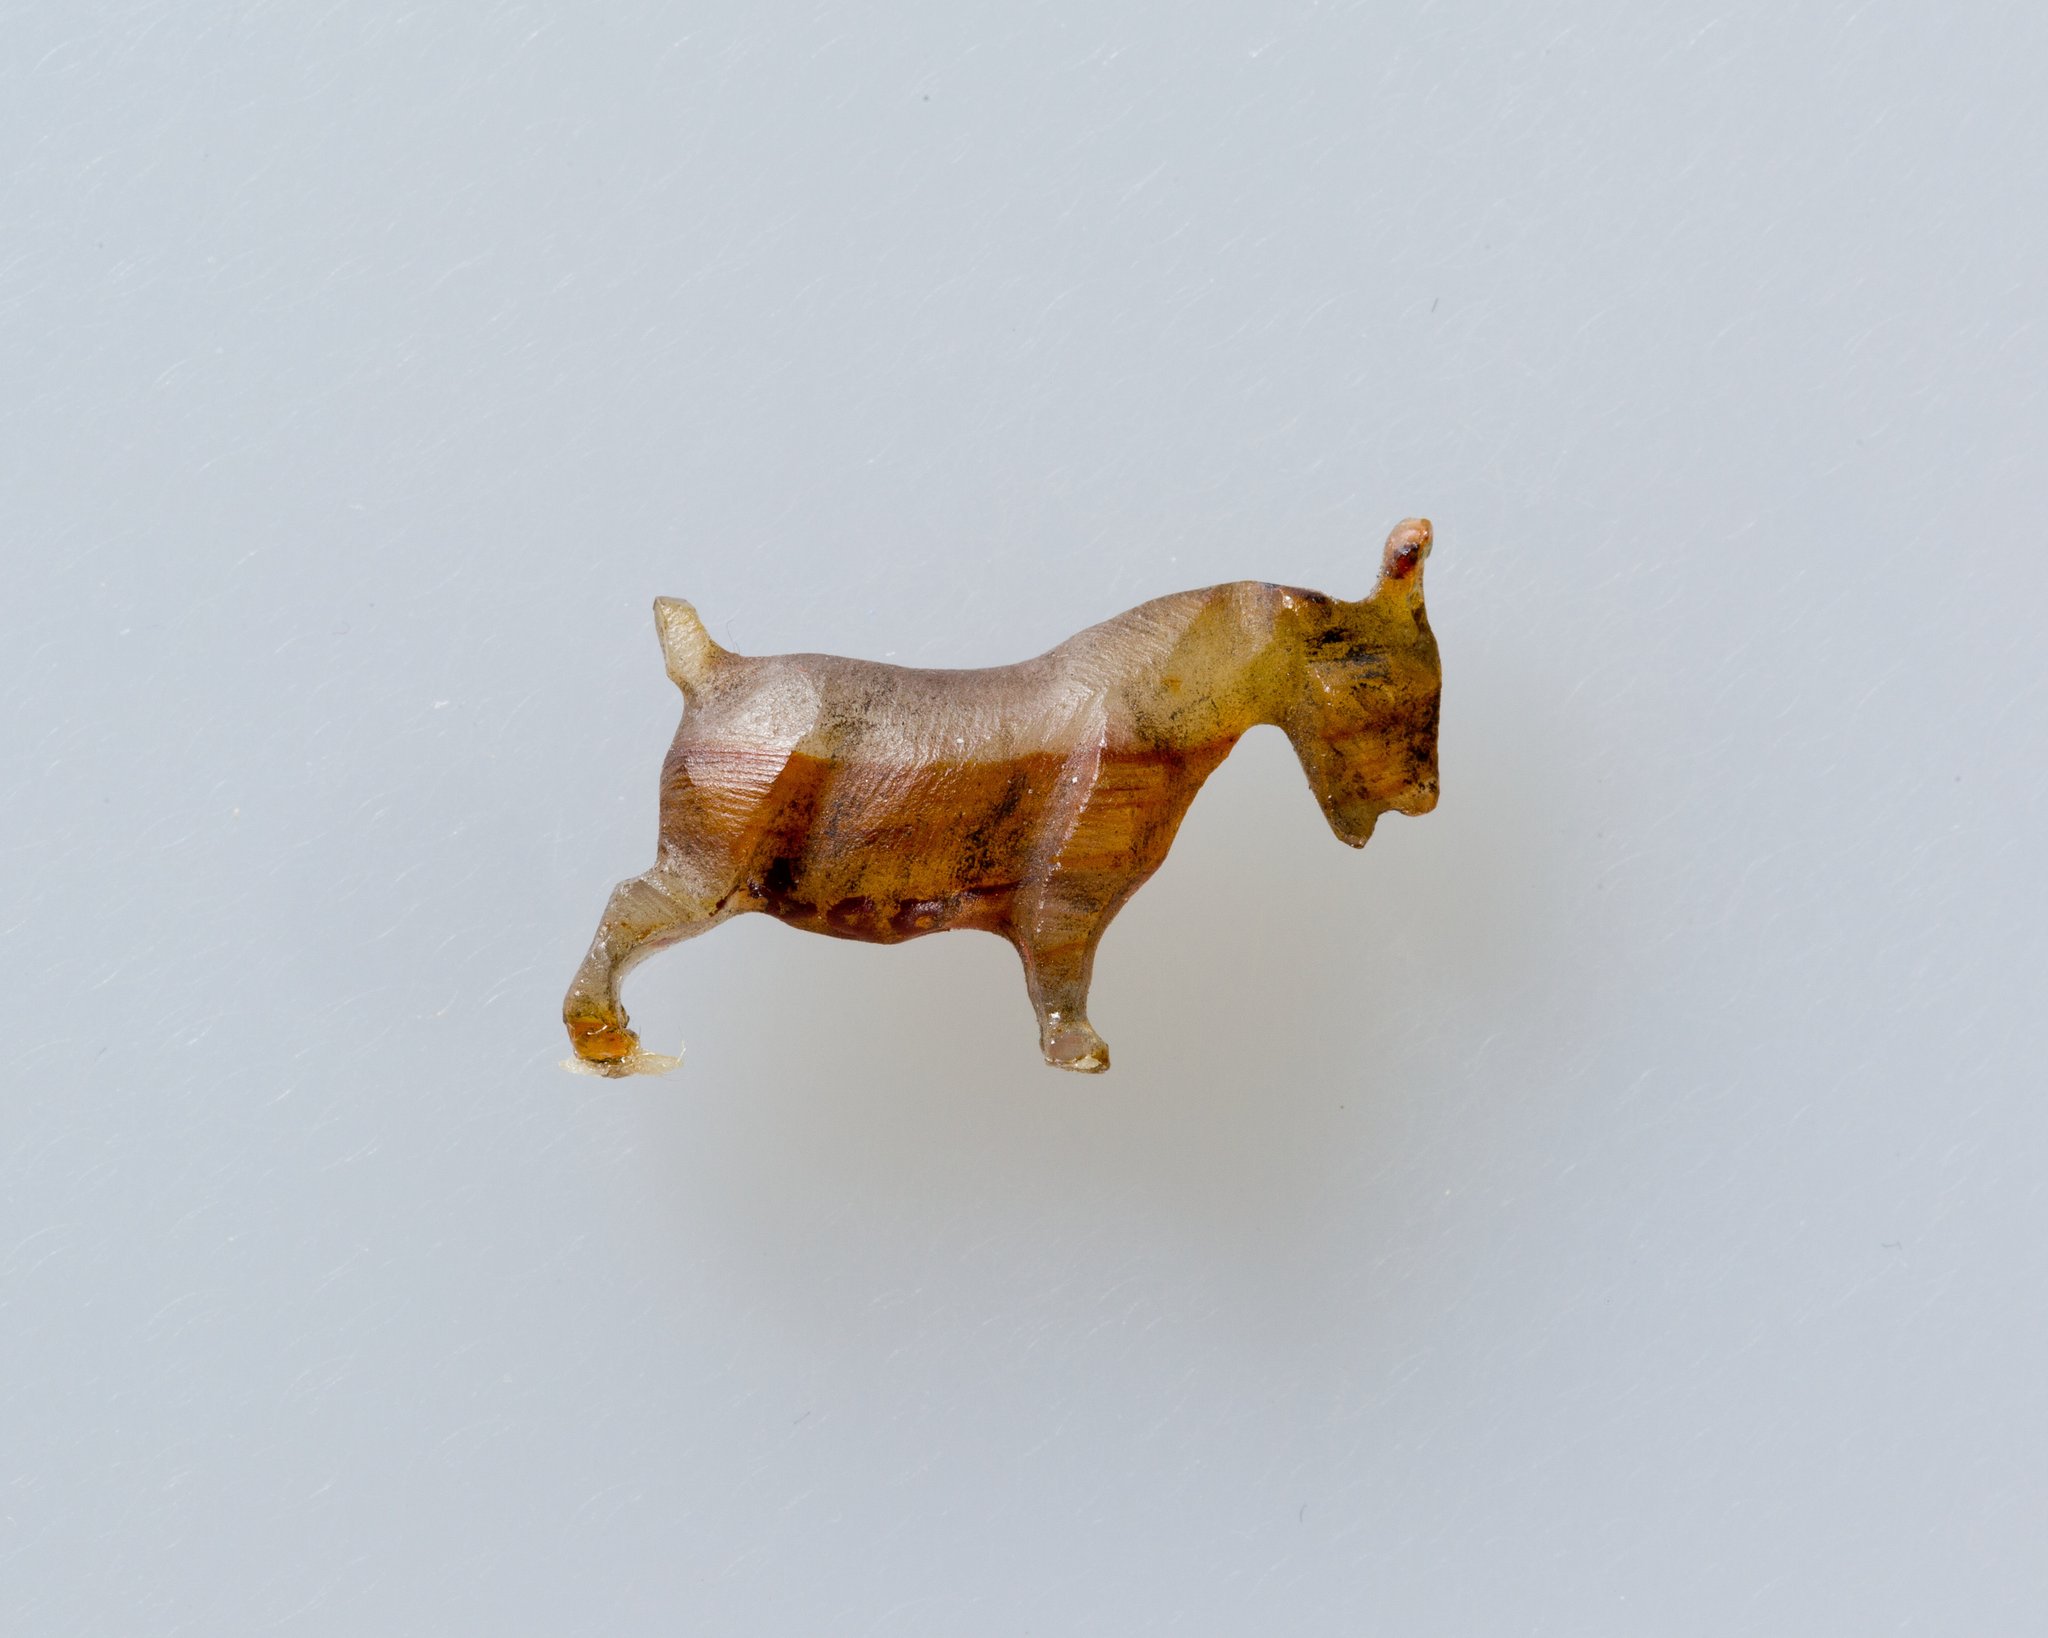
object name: amulet, goat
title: Goat amulet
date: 200 BCE-200 CE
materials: stone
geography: egypt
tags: goats